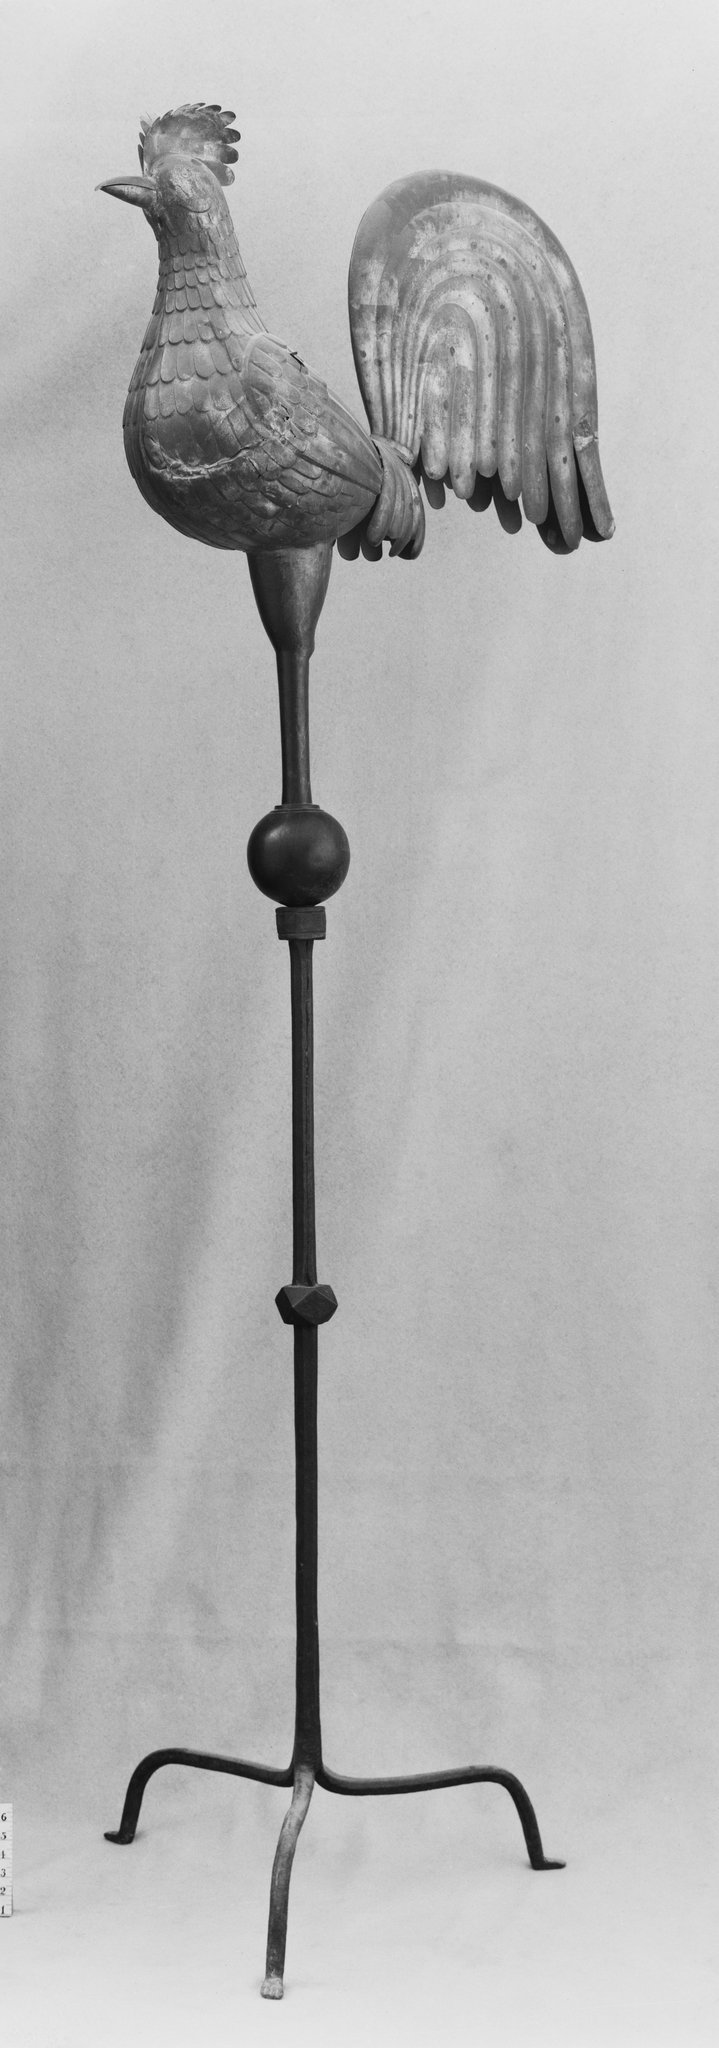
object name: weathercock and stand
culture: french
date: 1801-1900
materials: gilt copper, iron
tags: roosters